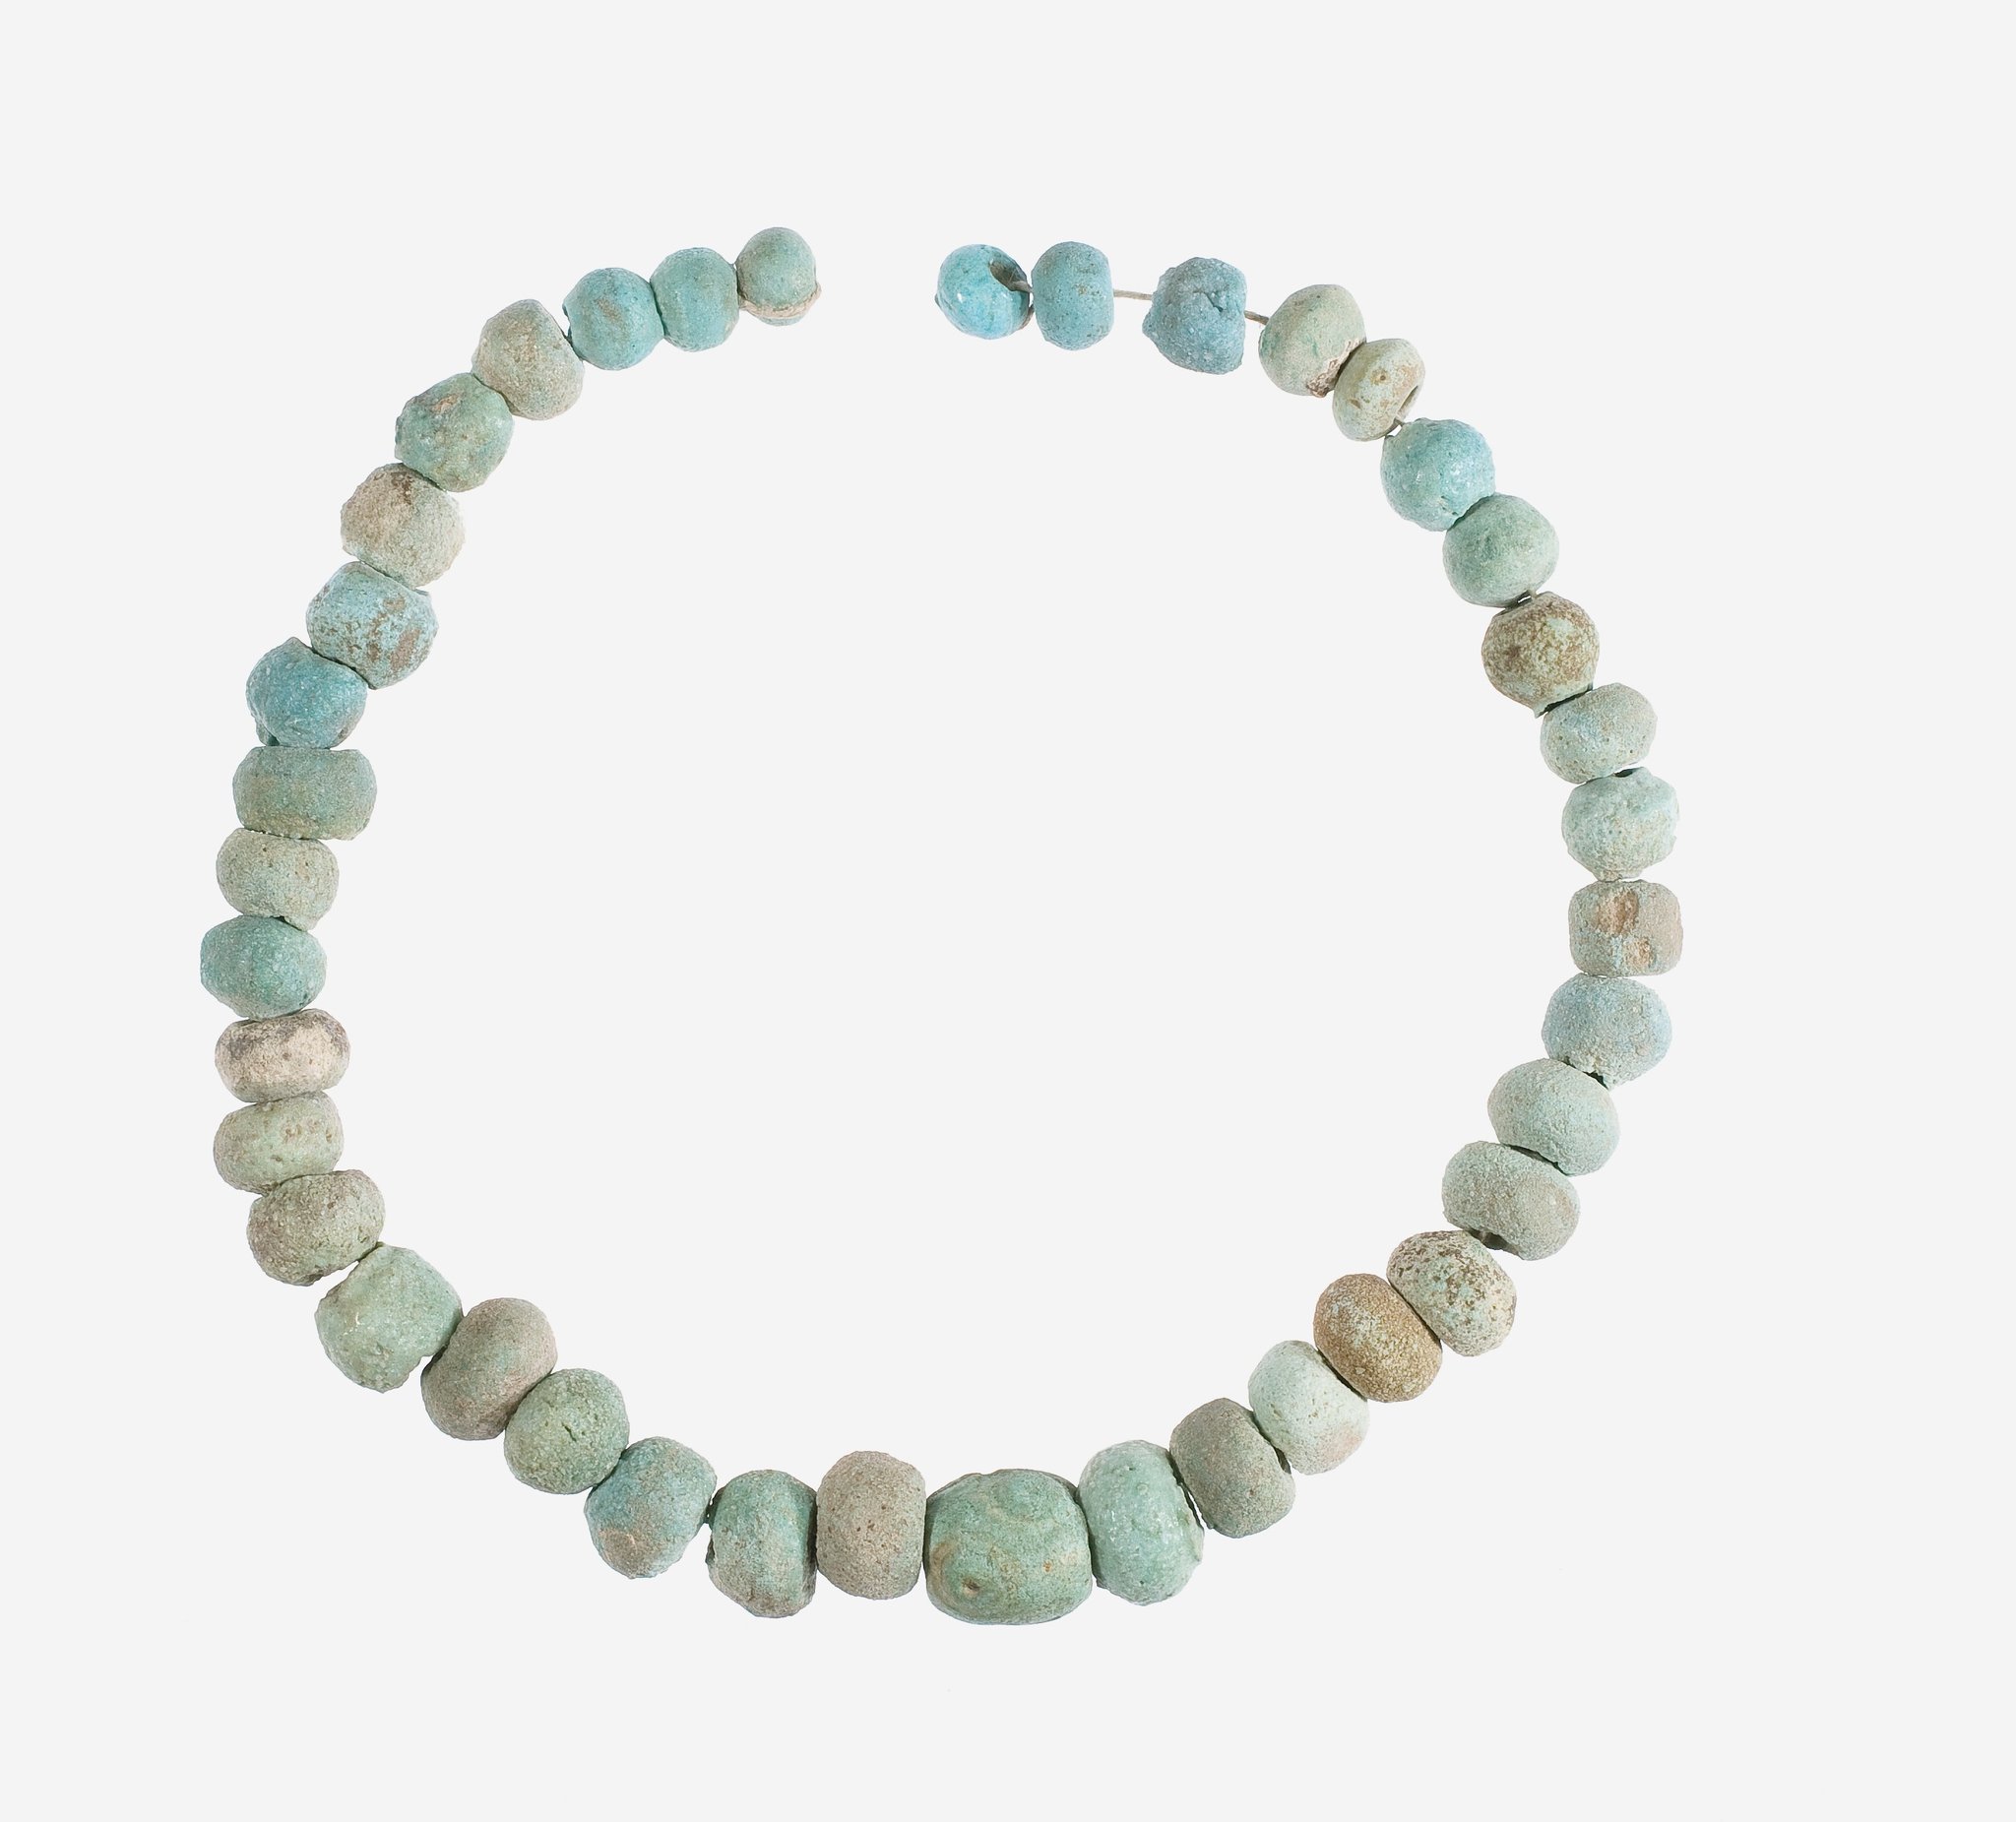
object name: bead, ball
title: String of Big Ball Beads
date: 1390-1352 BCE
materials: faience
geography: egypt